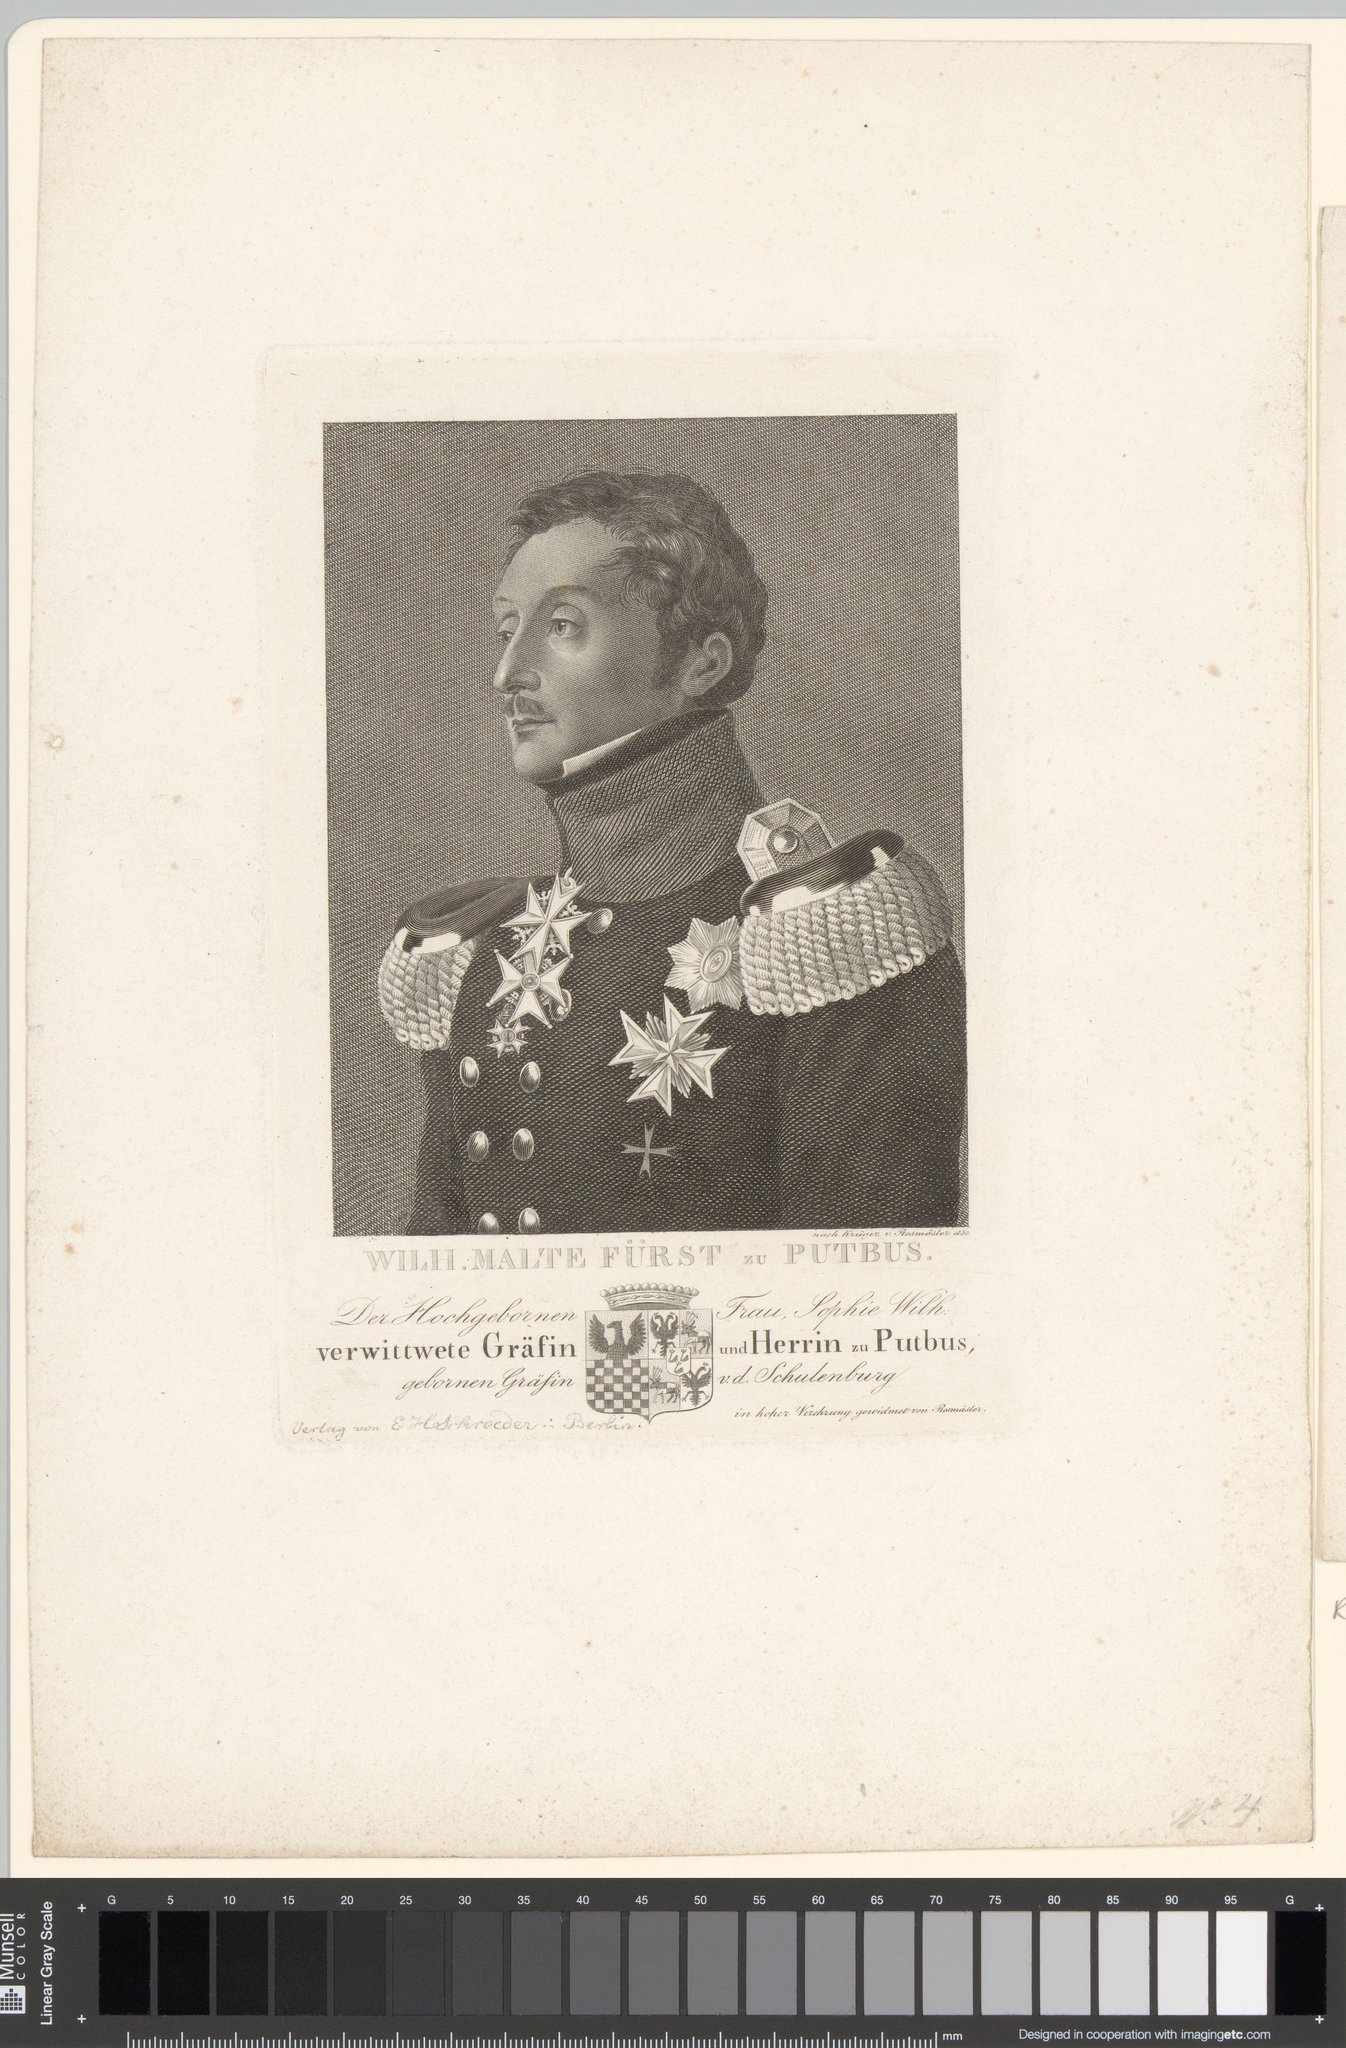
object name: print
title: Portret van Wilhelm Malte I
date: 1785-1858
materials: paper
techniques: engraving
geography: berlin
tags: historical persons, medals and other marks of military honour, armorial bearing, heraldry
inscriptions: collector's mark: Lugt 2228, : ‘Verlag von E.H. Schröder Berlin’